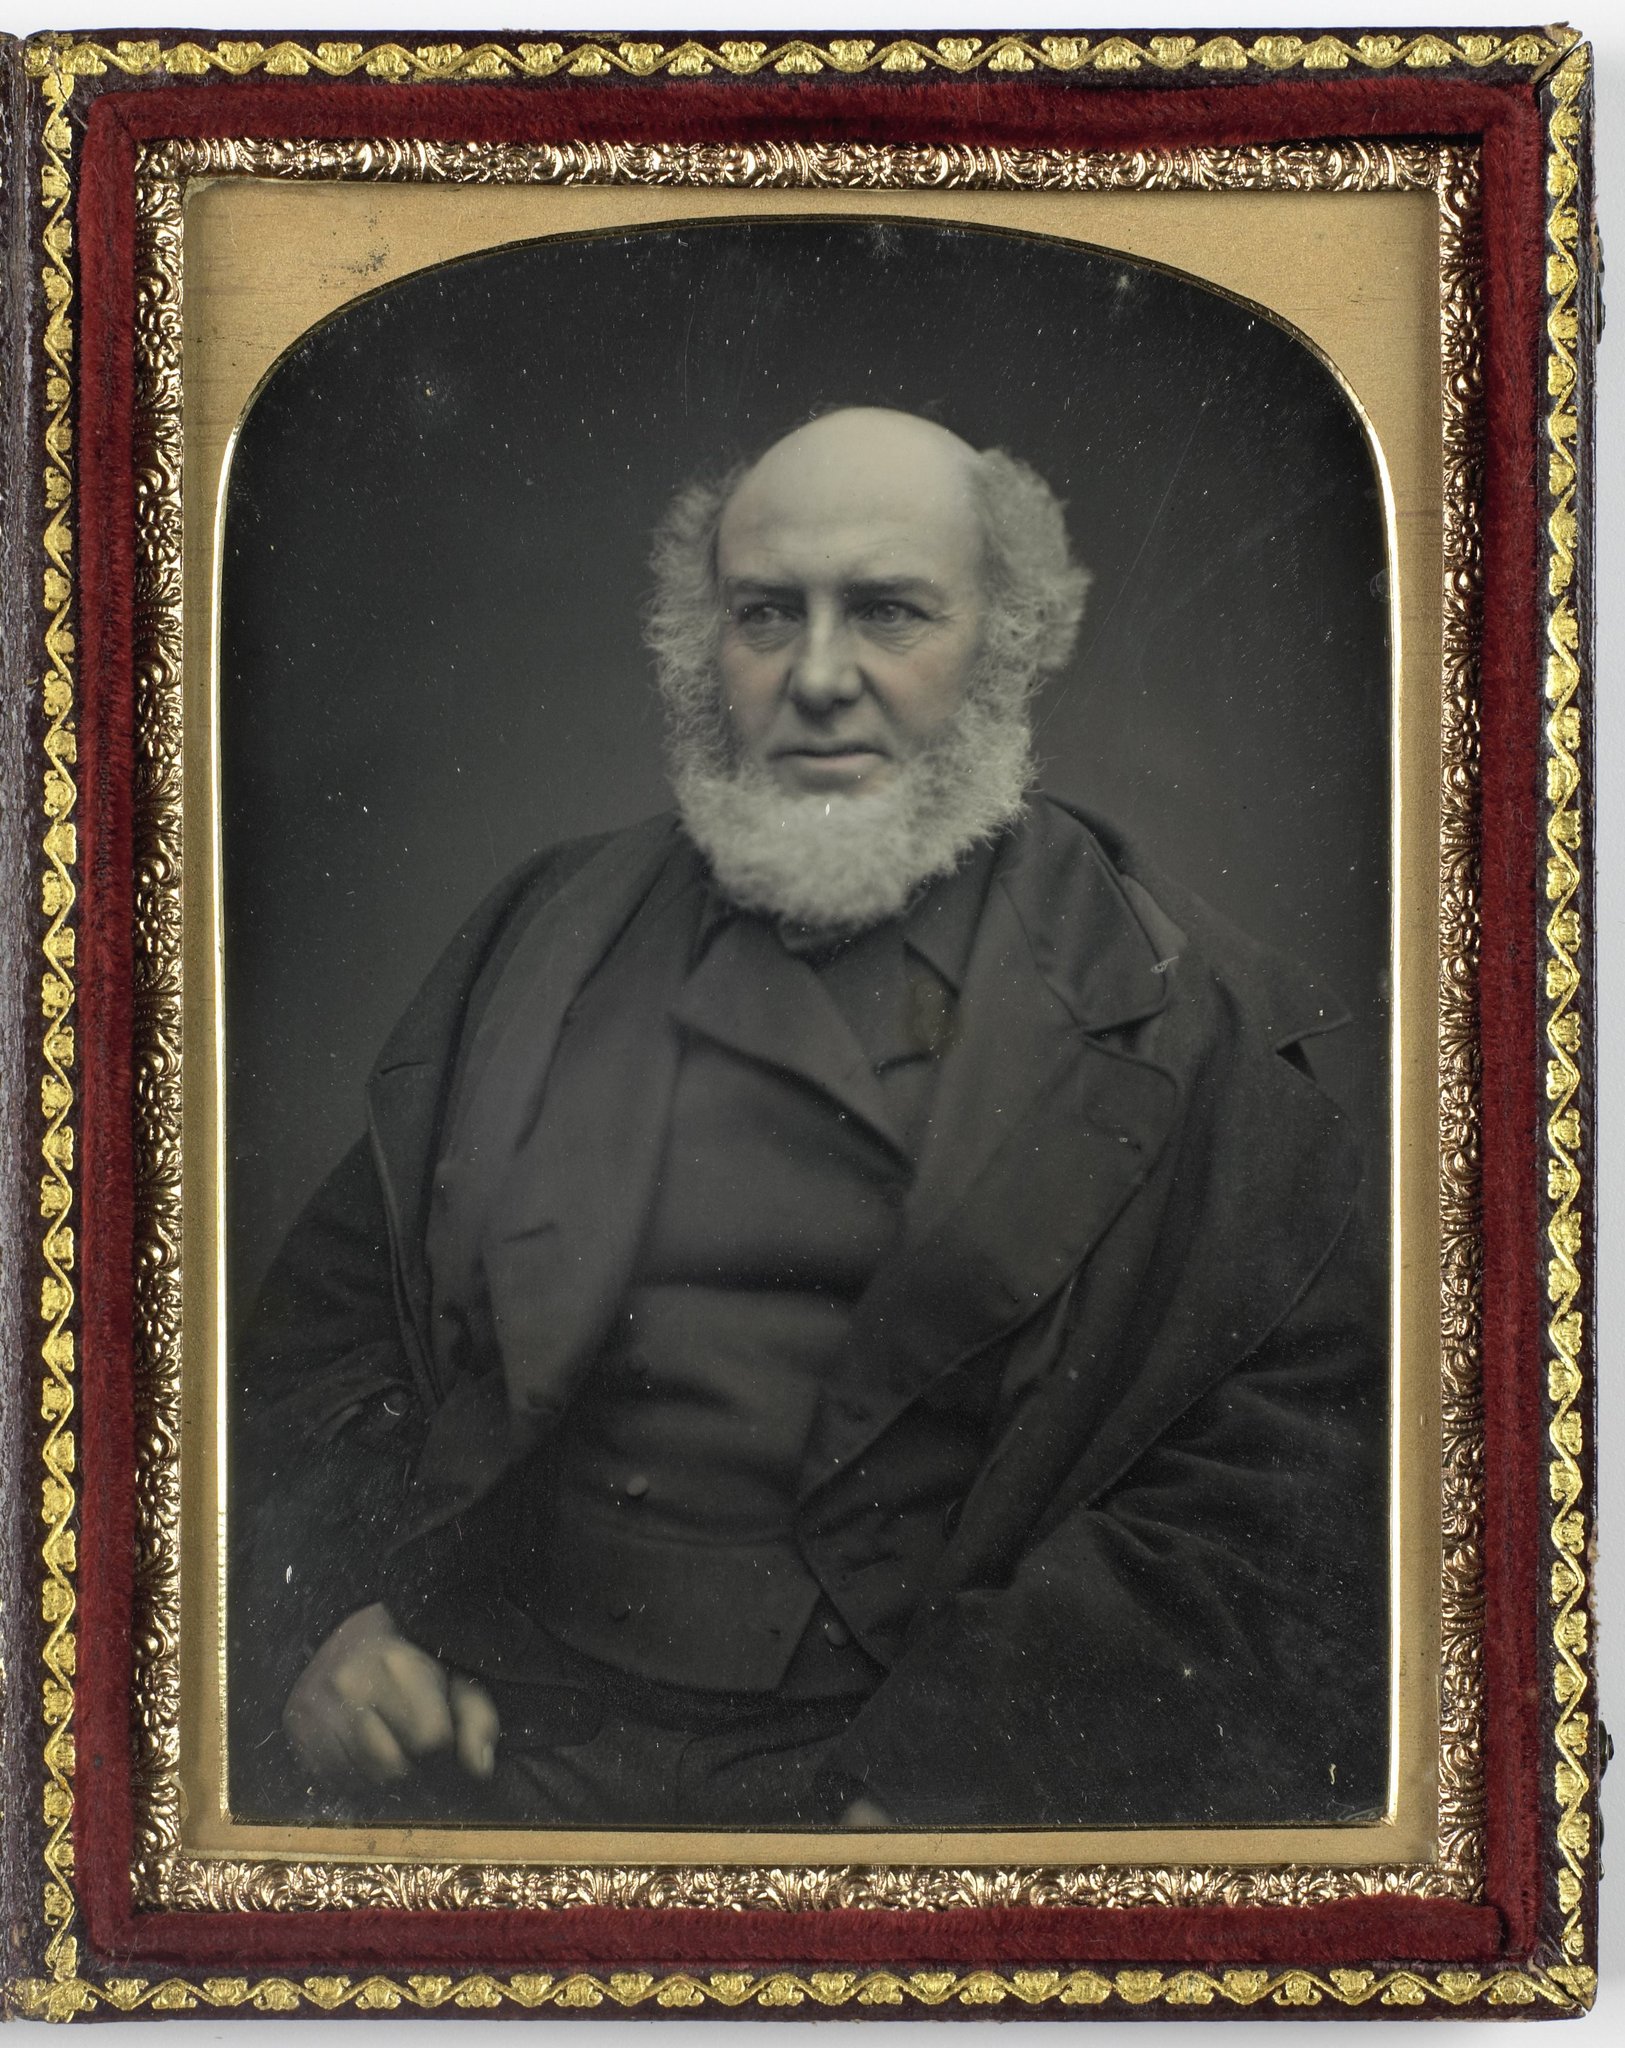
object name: photograph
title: Portret van een onbekende man met baard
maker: Anonymous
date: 1841-1850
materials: copper, glass, leather, velvet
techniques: daguerreotype, hand coloring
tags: old man, historical persons not known by name